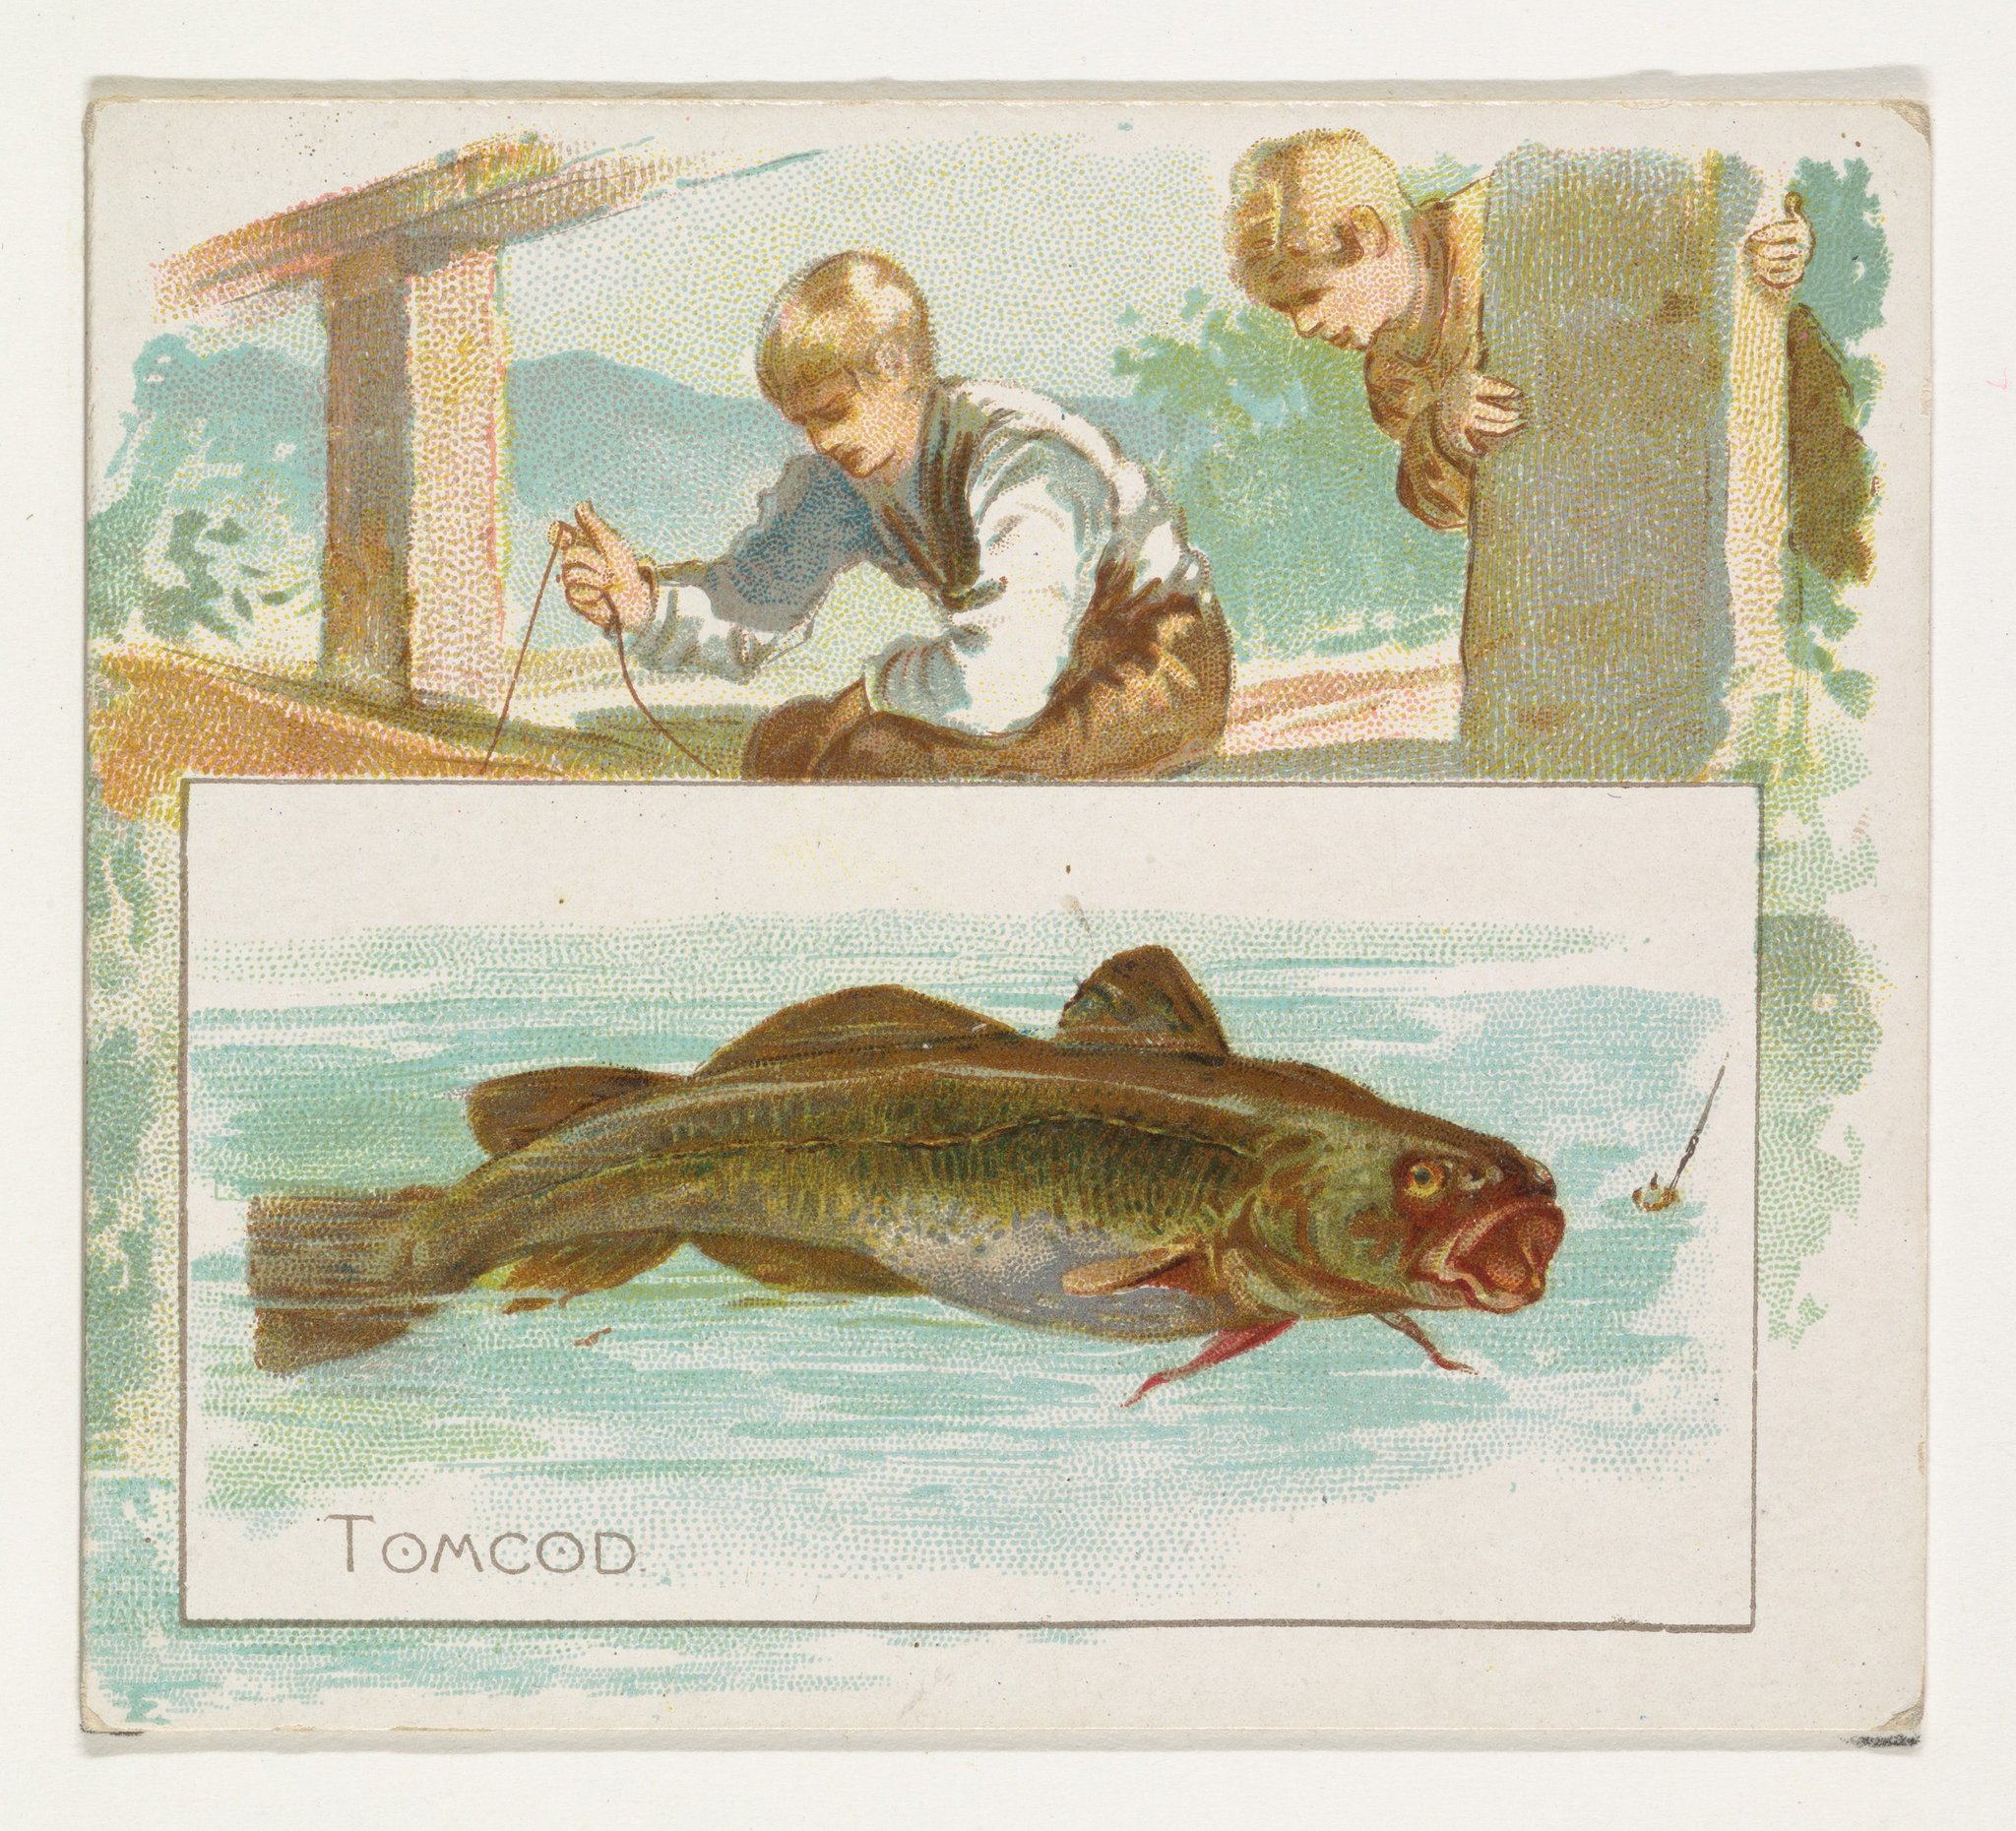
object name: print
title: Tomcod, from Fish from American Waters series (N39) for Allen & Ginter Cigarettes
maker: allen & ginter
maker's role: publisher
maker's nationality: american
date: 1889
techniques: color lithograph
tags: boys,fishing,fish